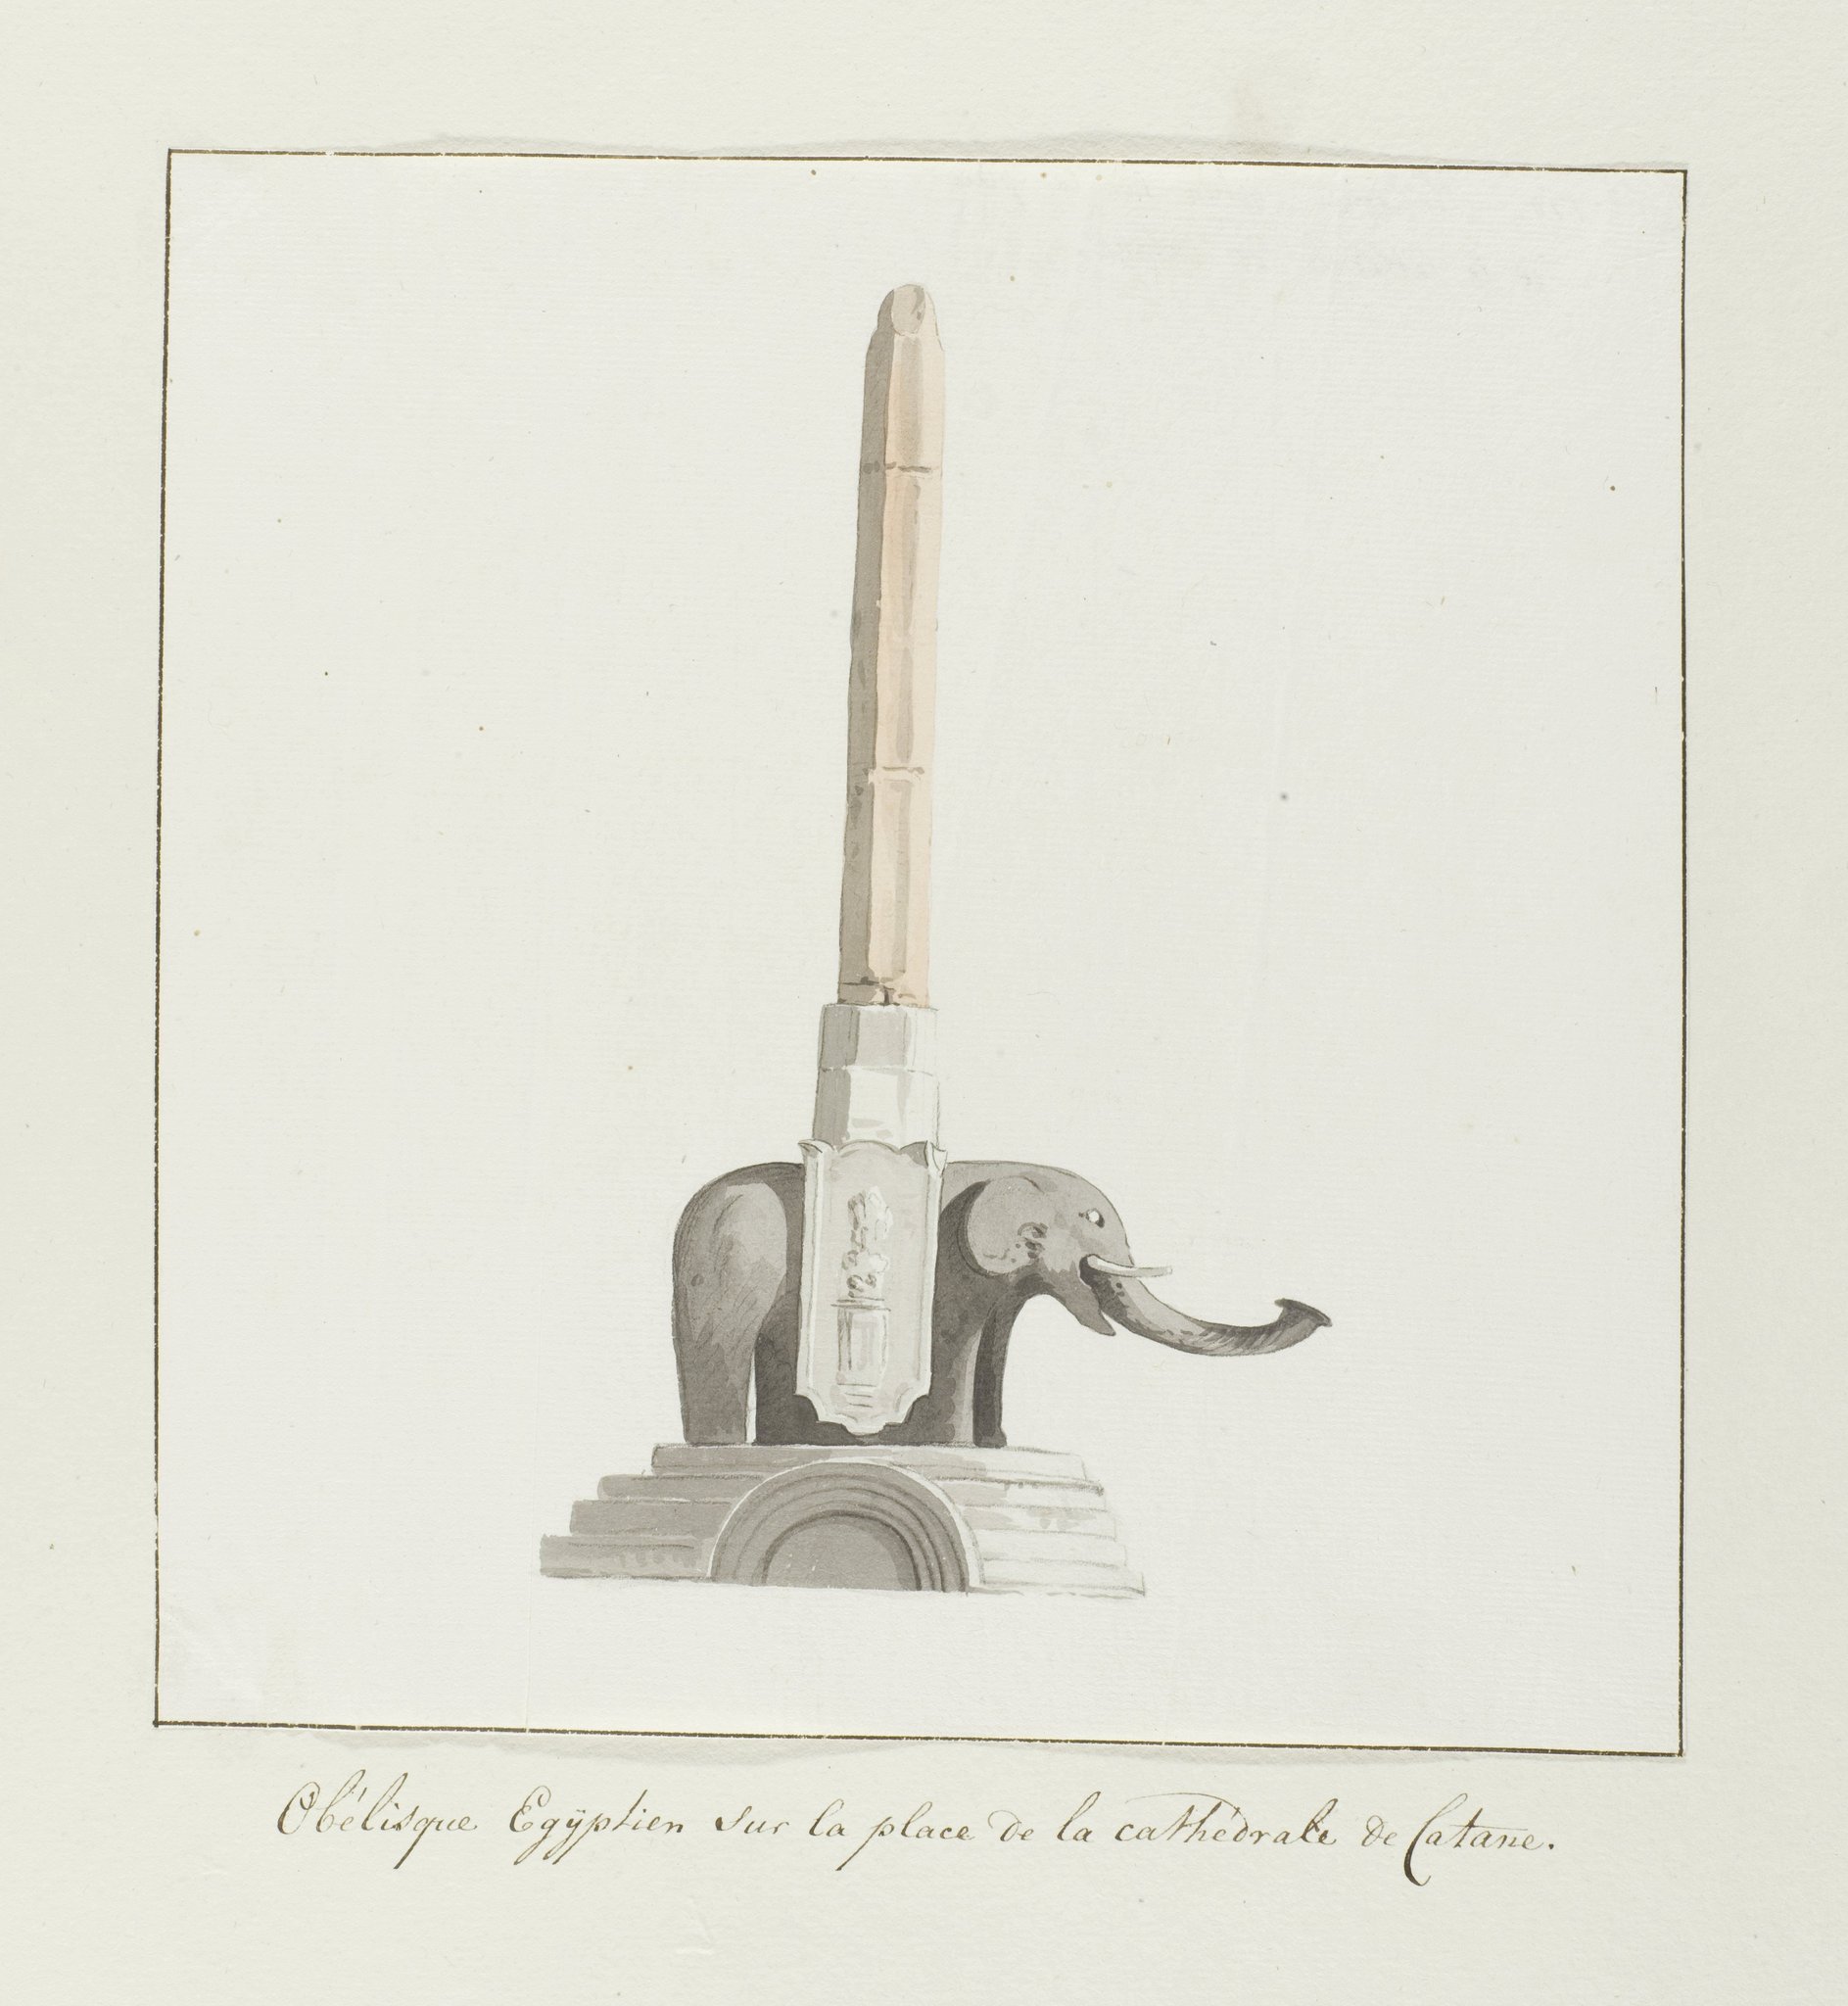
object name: watercolor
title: Egyptische obelisk op plein voor kathedraal van Catanië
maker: louis ducros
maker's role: draughtsman, print maker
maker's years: 1748-1810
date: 1778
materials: chalk, paper, watercolor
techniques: brush, pen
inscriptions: inscription: ‘No 179 Obélisque Egyptien sur la place de la cathédrale de Catane’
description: Egyptische obelisk op rug van olifant als monument op plein voor kathedraal van Catanië. Tekening uit het album 'Voyage en Italie, en Sicile et à Malte', 1778.